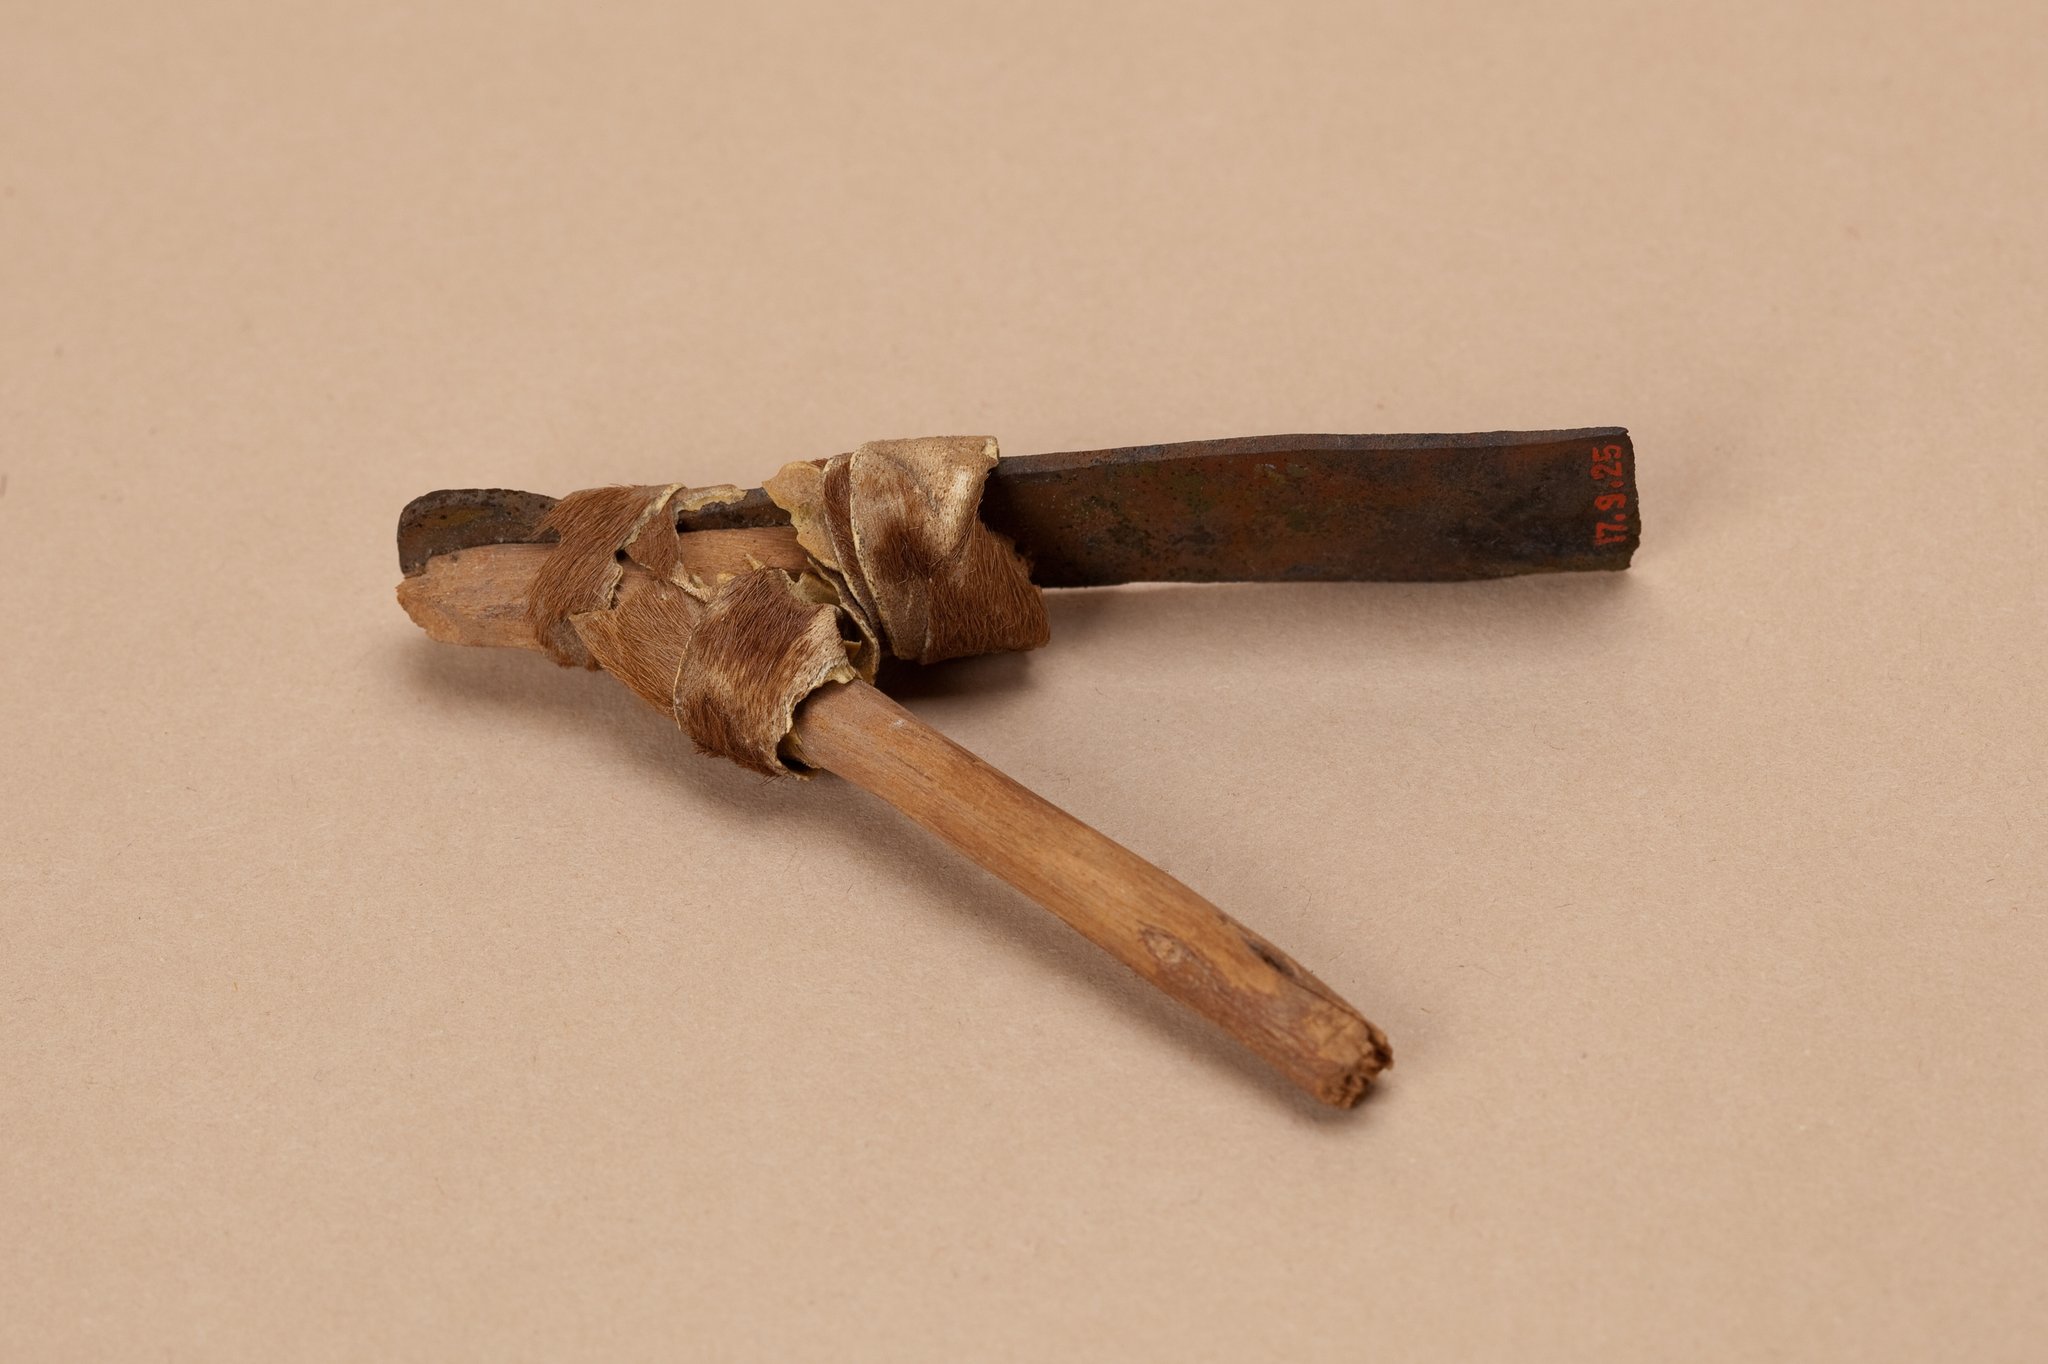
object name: model adze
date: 1981-1802 BCE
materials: copper, wood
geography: egypt